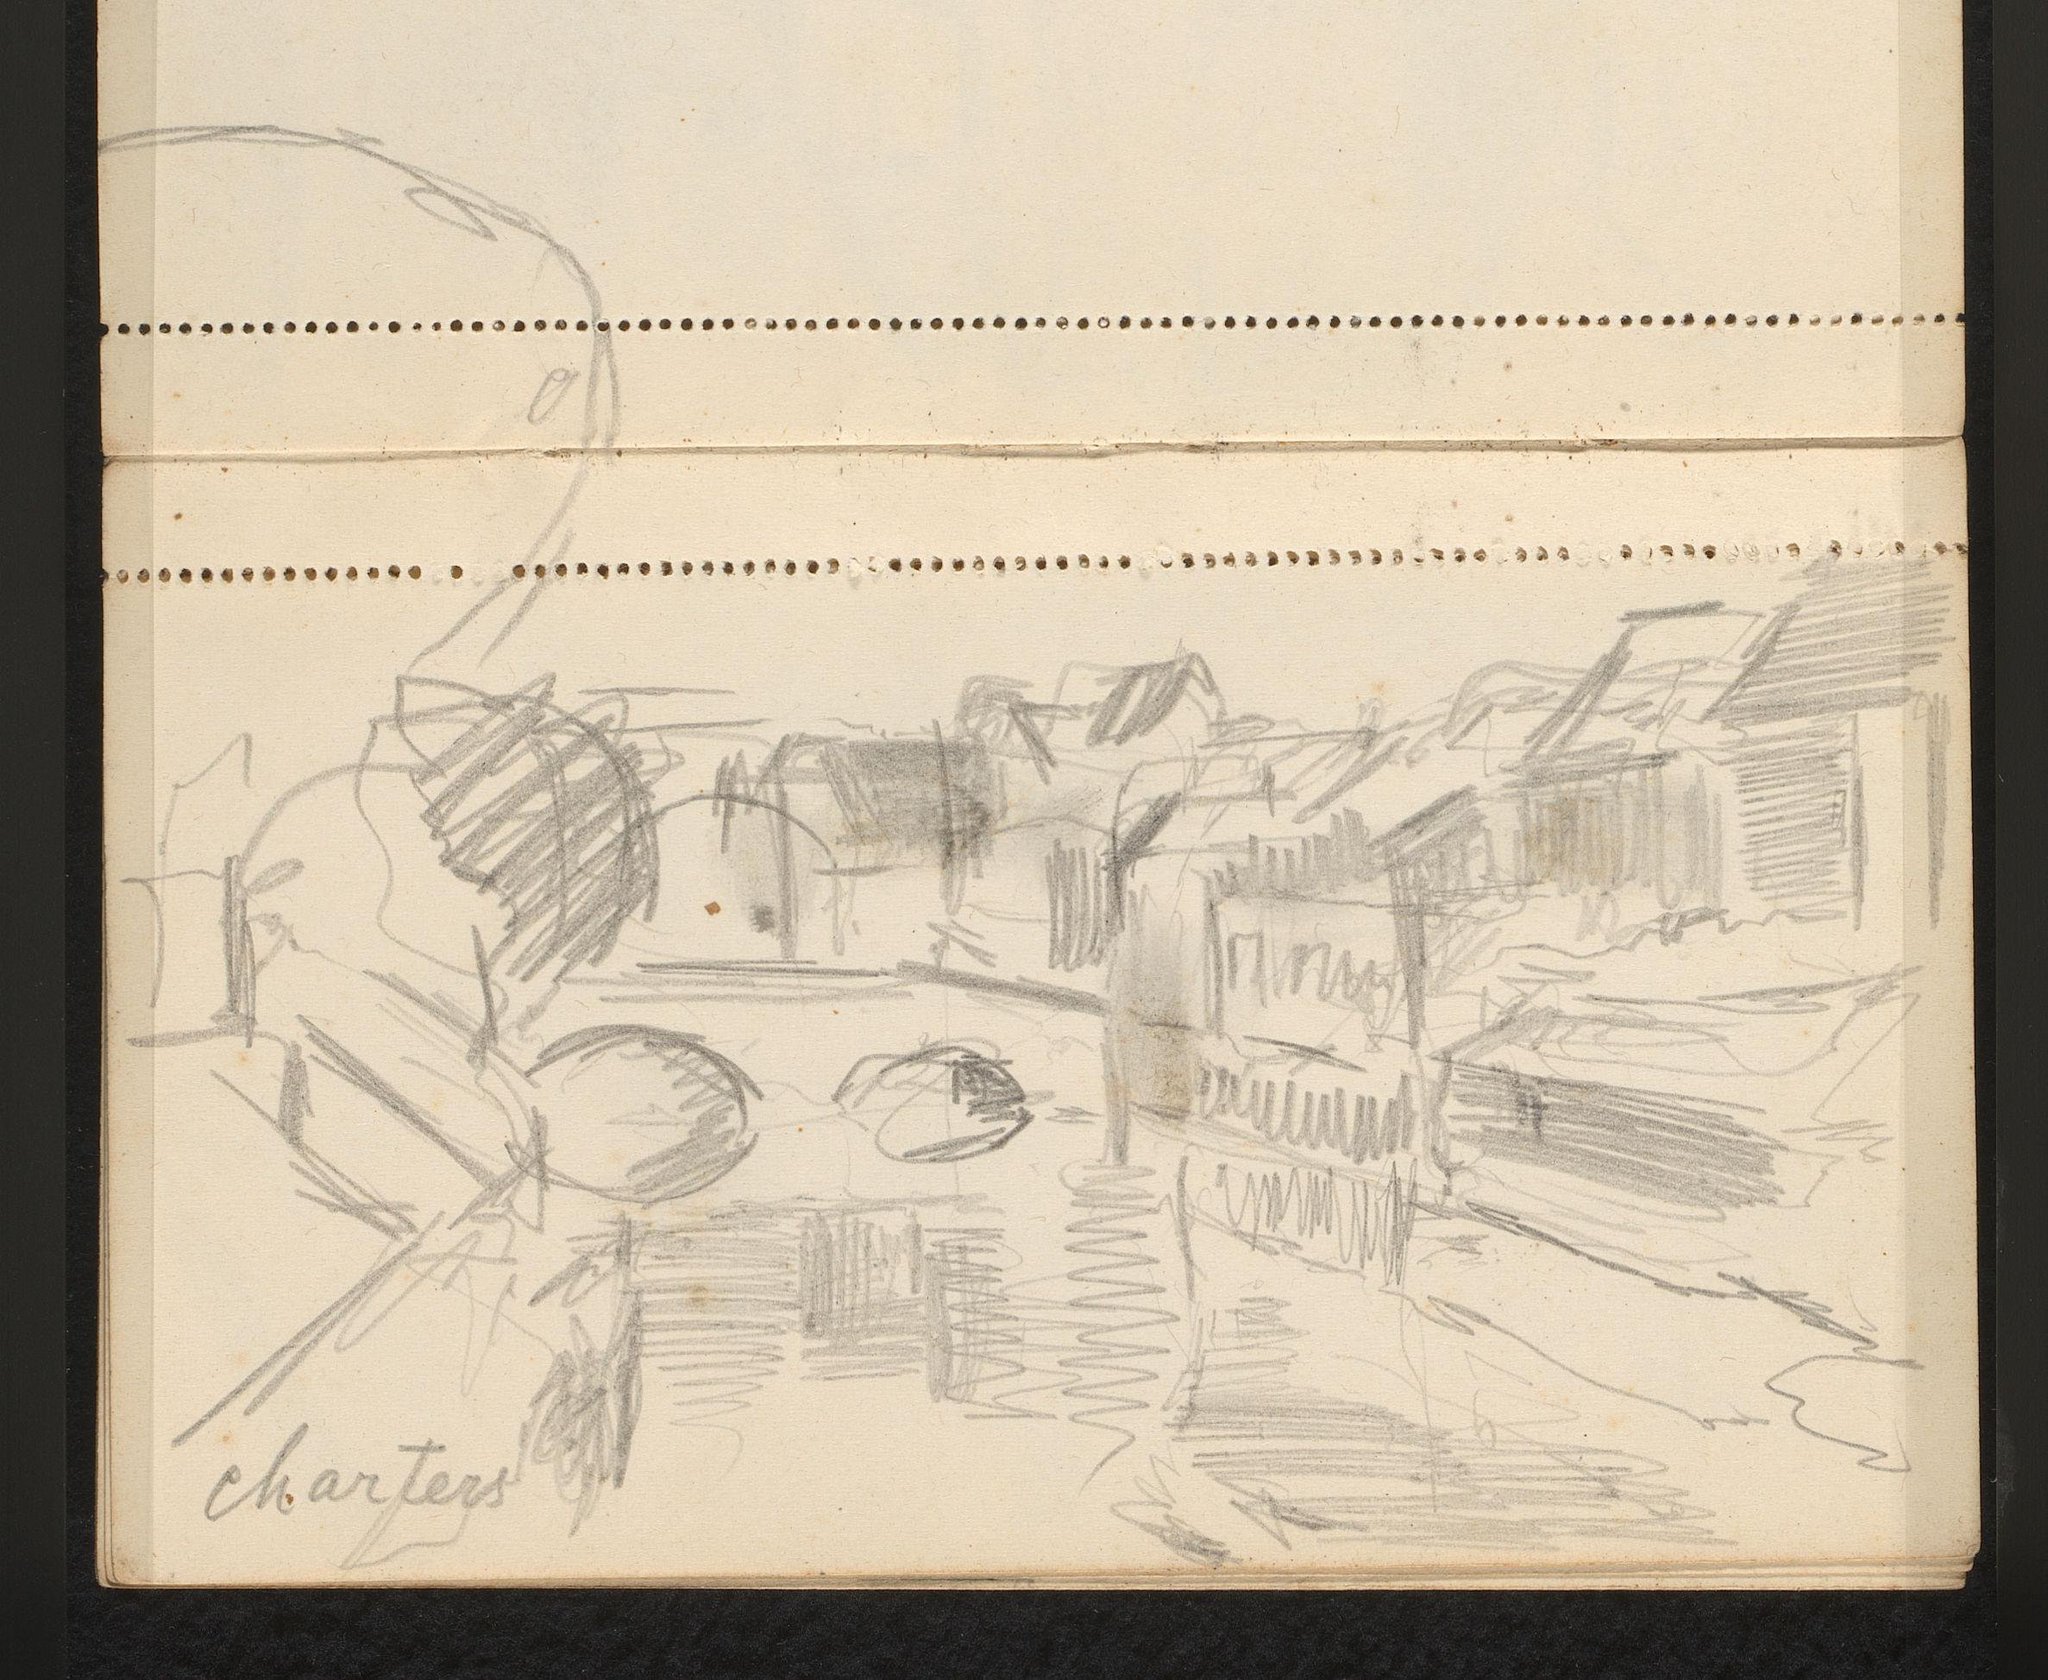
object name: sketchbook leaf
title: Gezicht op een brug over de Eure te Chartres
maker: gerrit van blaaderen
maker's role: draughtsman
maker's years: 1873-1935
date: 1927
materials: paper, pencil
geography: chartres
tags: bridge in city across river, canal, etc.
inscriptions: annotation: ‘charters’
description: Bladen 2 verso en 3 recto uit een schetsboek met 33 bladen.